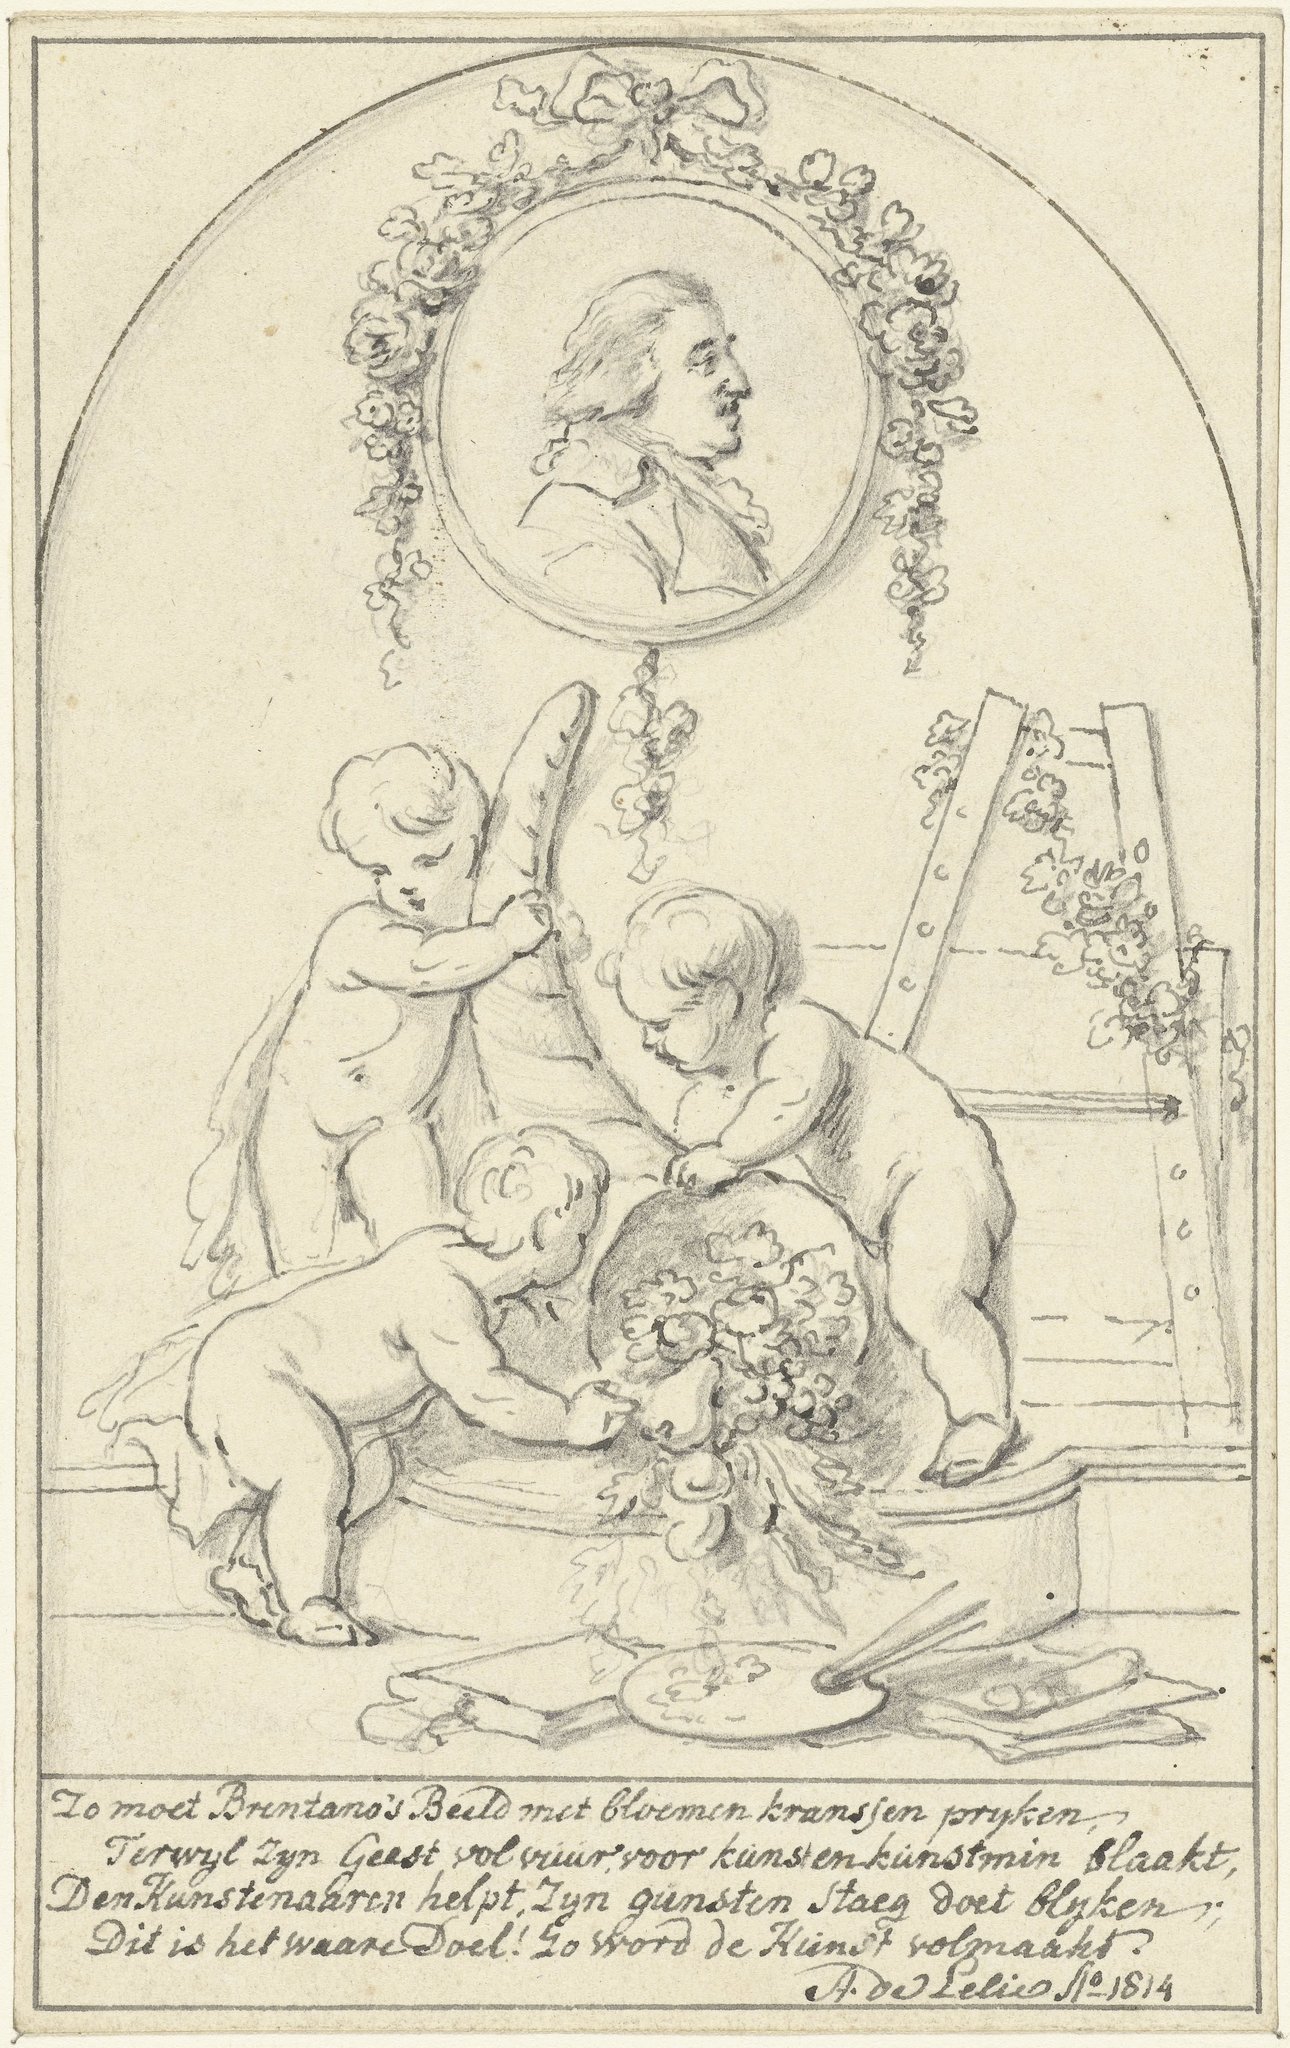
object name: drawing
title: Decoratief ontwerp met putti met hoorn des overvloeds met een portret van Josephus Augustinus Brentano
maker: adriaan de lelie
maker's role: draughtsman, painter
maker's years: 1755-1820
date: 1814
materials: ink, paper, pencil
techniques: pen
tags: historical persons